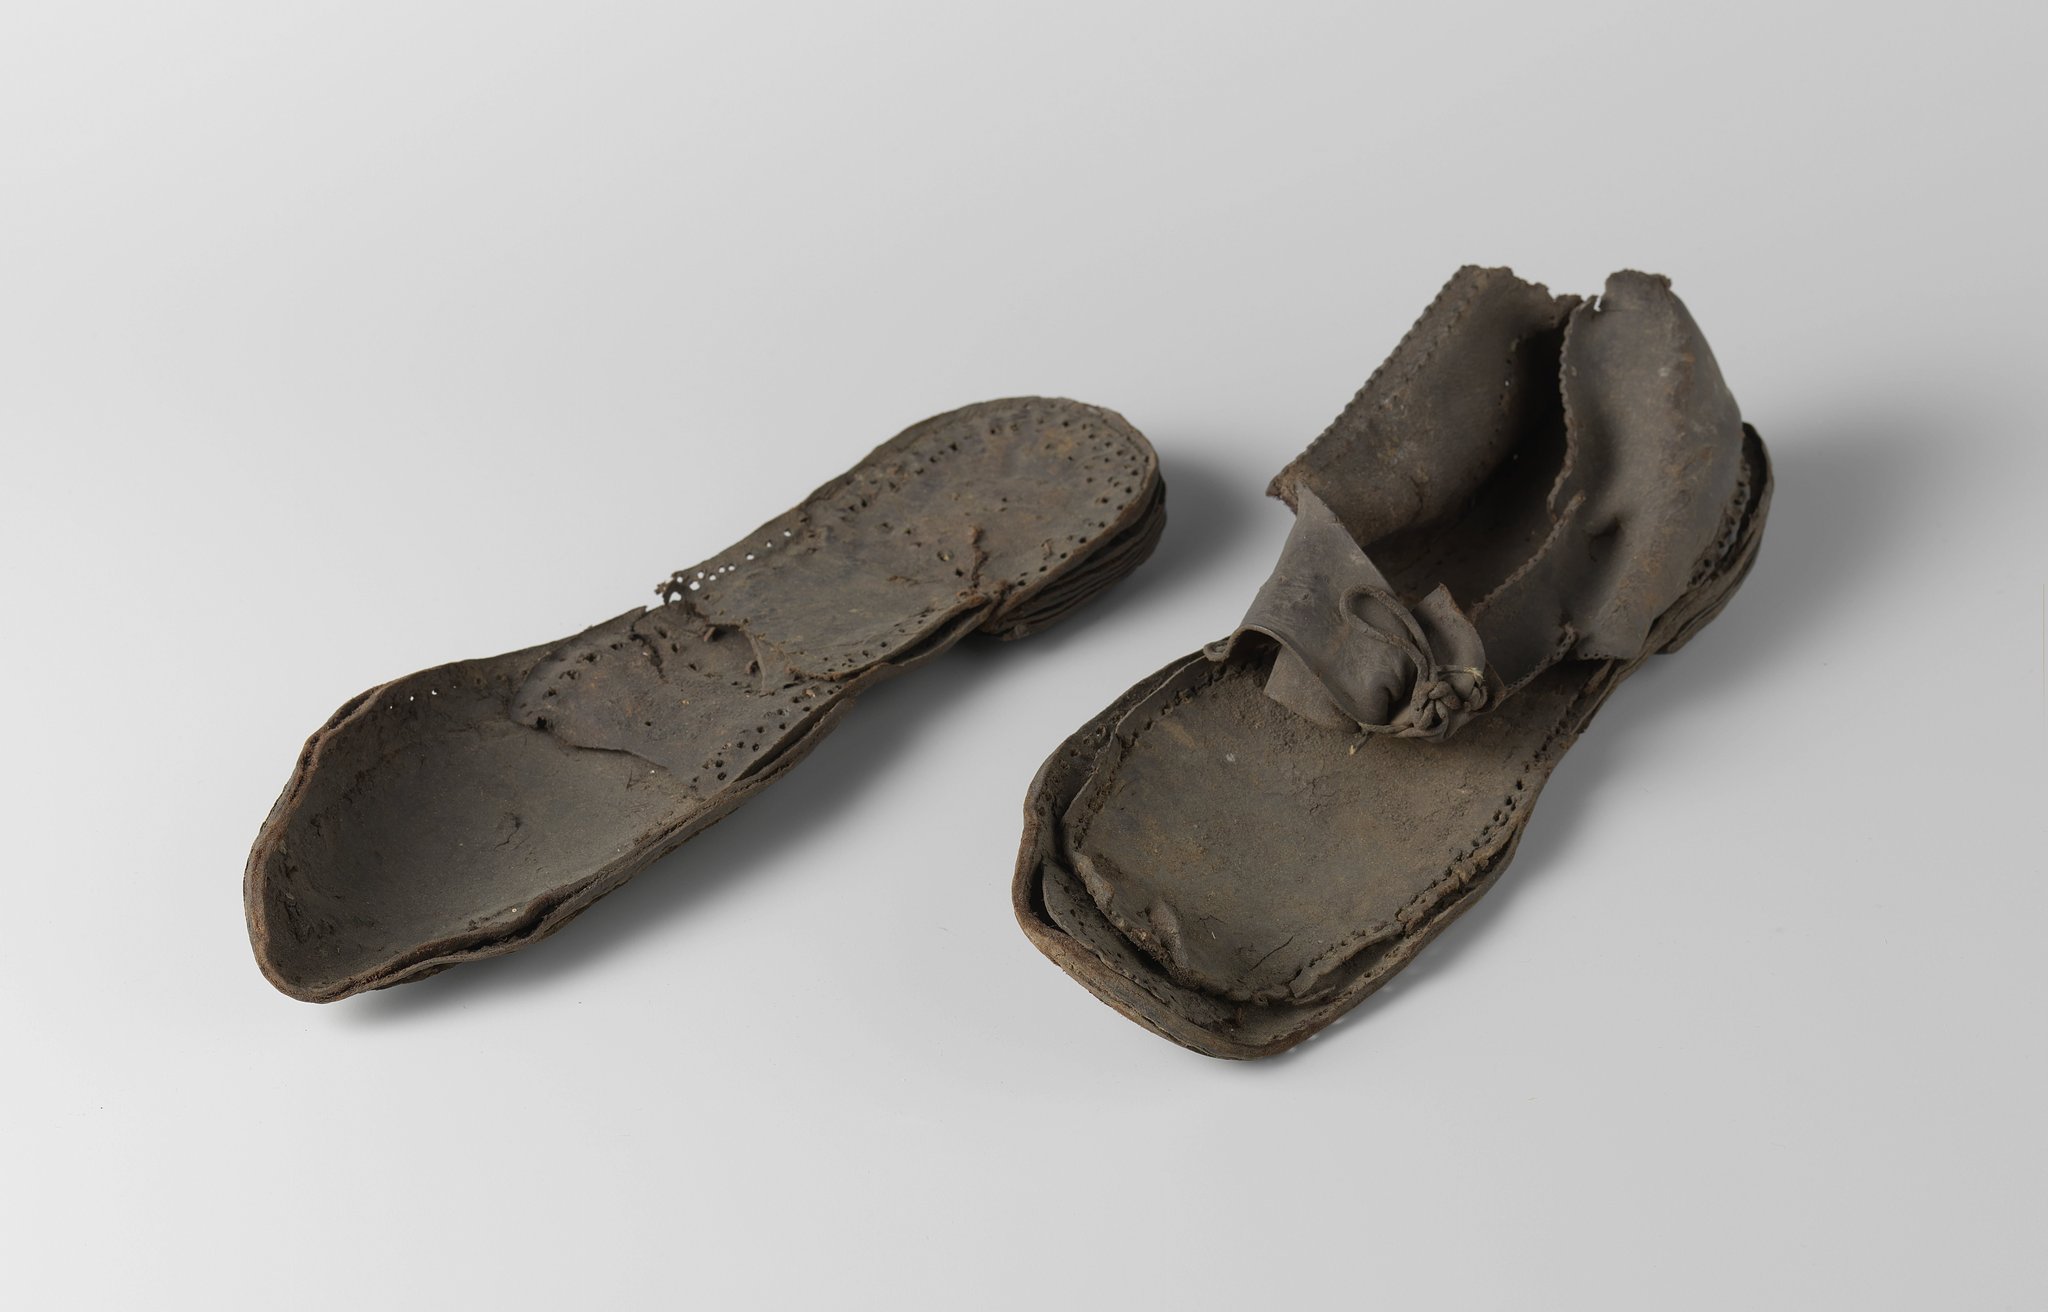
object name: womenswear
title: Leren damesschoen, gedragen bij de executie van freule Johanna Magdalena Catharina Judith van Dorth tot Holthuysen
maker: Anonymous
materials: iron, leather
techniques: nailed, sewing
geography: netherlands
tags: johanna magdalena catharina judith van dorth, winterswijk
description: Gedragen door freule Judith van Dorth tot Holthuysen, stiftsjuffer te Grevelsberg, bij haar executie te Winterswijk, 24 november 1799 's morgens tussen tien en elf uur. Zij werd ter dood veroordeeld door de krijgsraad, opgericht door de fransman Girod, wegens haar geuite sympathieën voor Oranje. Afkomstig uit het graf van de freule in de N.H. kerk te Lichtenvoorde. De schoenen werden aangetroffen in 1929 toen bij een verbouwing van de kerk van Lichtenvoorde het graf van Freule Judith van Dorth tot Holthuizen werd gevonden. Zij bleef in de Franse Tijd openlijk loyaal aan de Oranjes, en werd in 1799 door de Patriotten gearresteerd, berecht en geexecuteerd. Het lichaam is vervolgens herbegraven; haar schoenen en de blinddoek die ze droeg zijn echter bewaard.